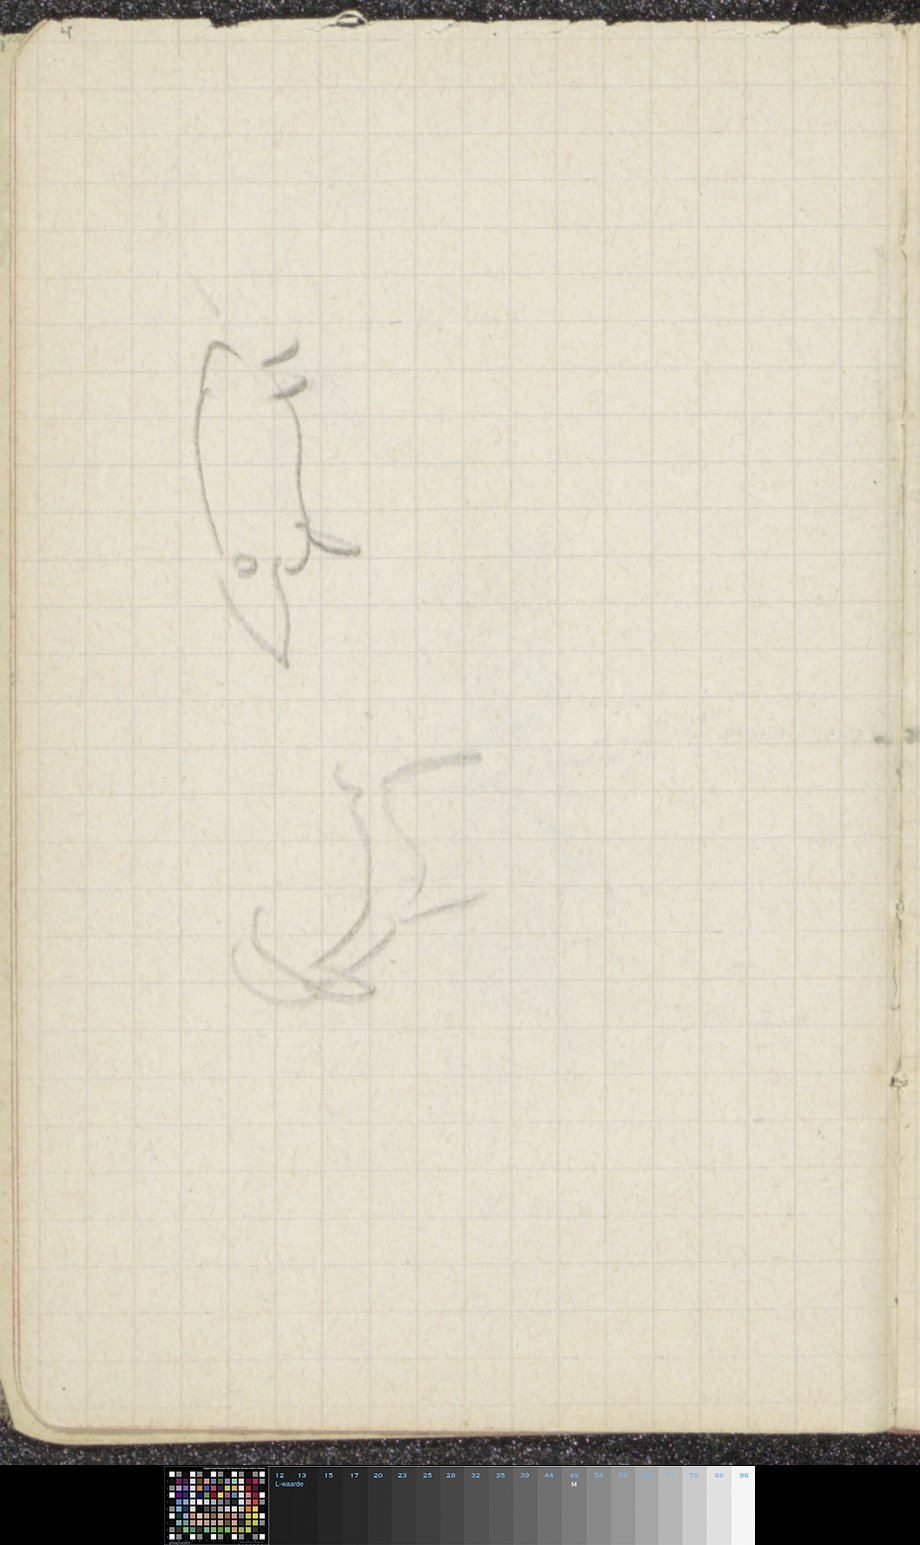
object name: sketchbook leaf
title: Bok en dier met vier poten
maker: marius bauer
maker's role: draughtsman, print maker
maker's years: 1867-1932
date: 1902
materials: pencil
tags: goat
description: Pagina 4 uit een schetsboek met 23 bladen.